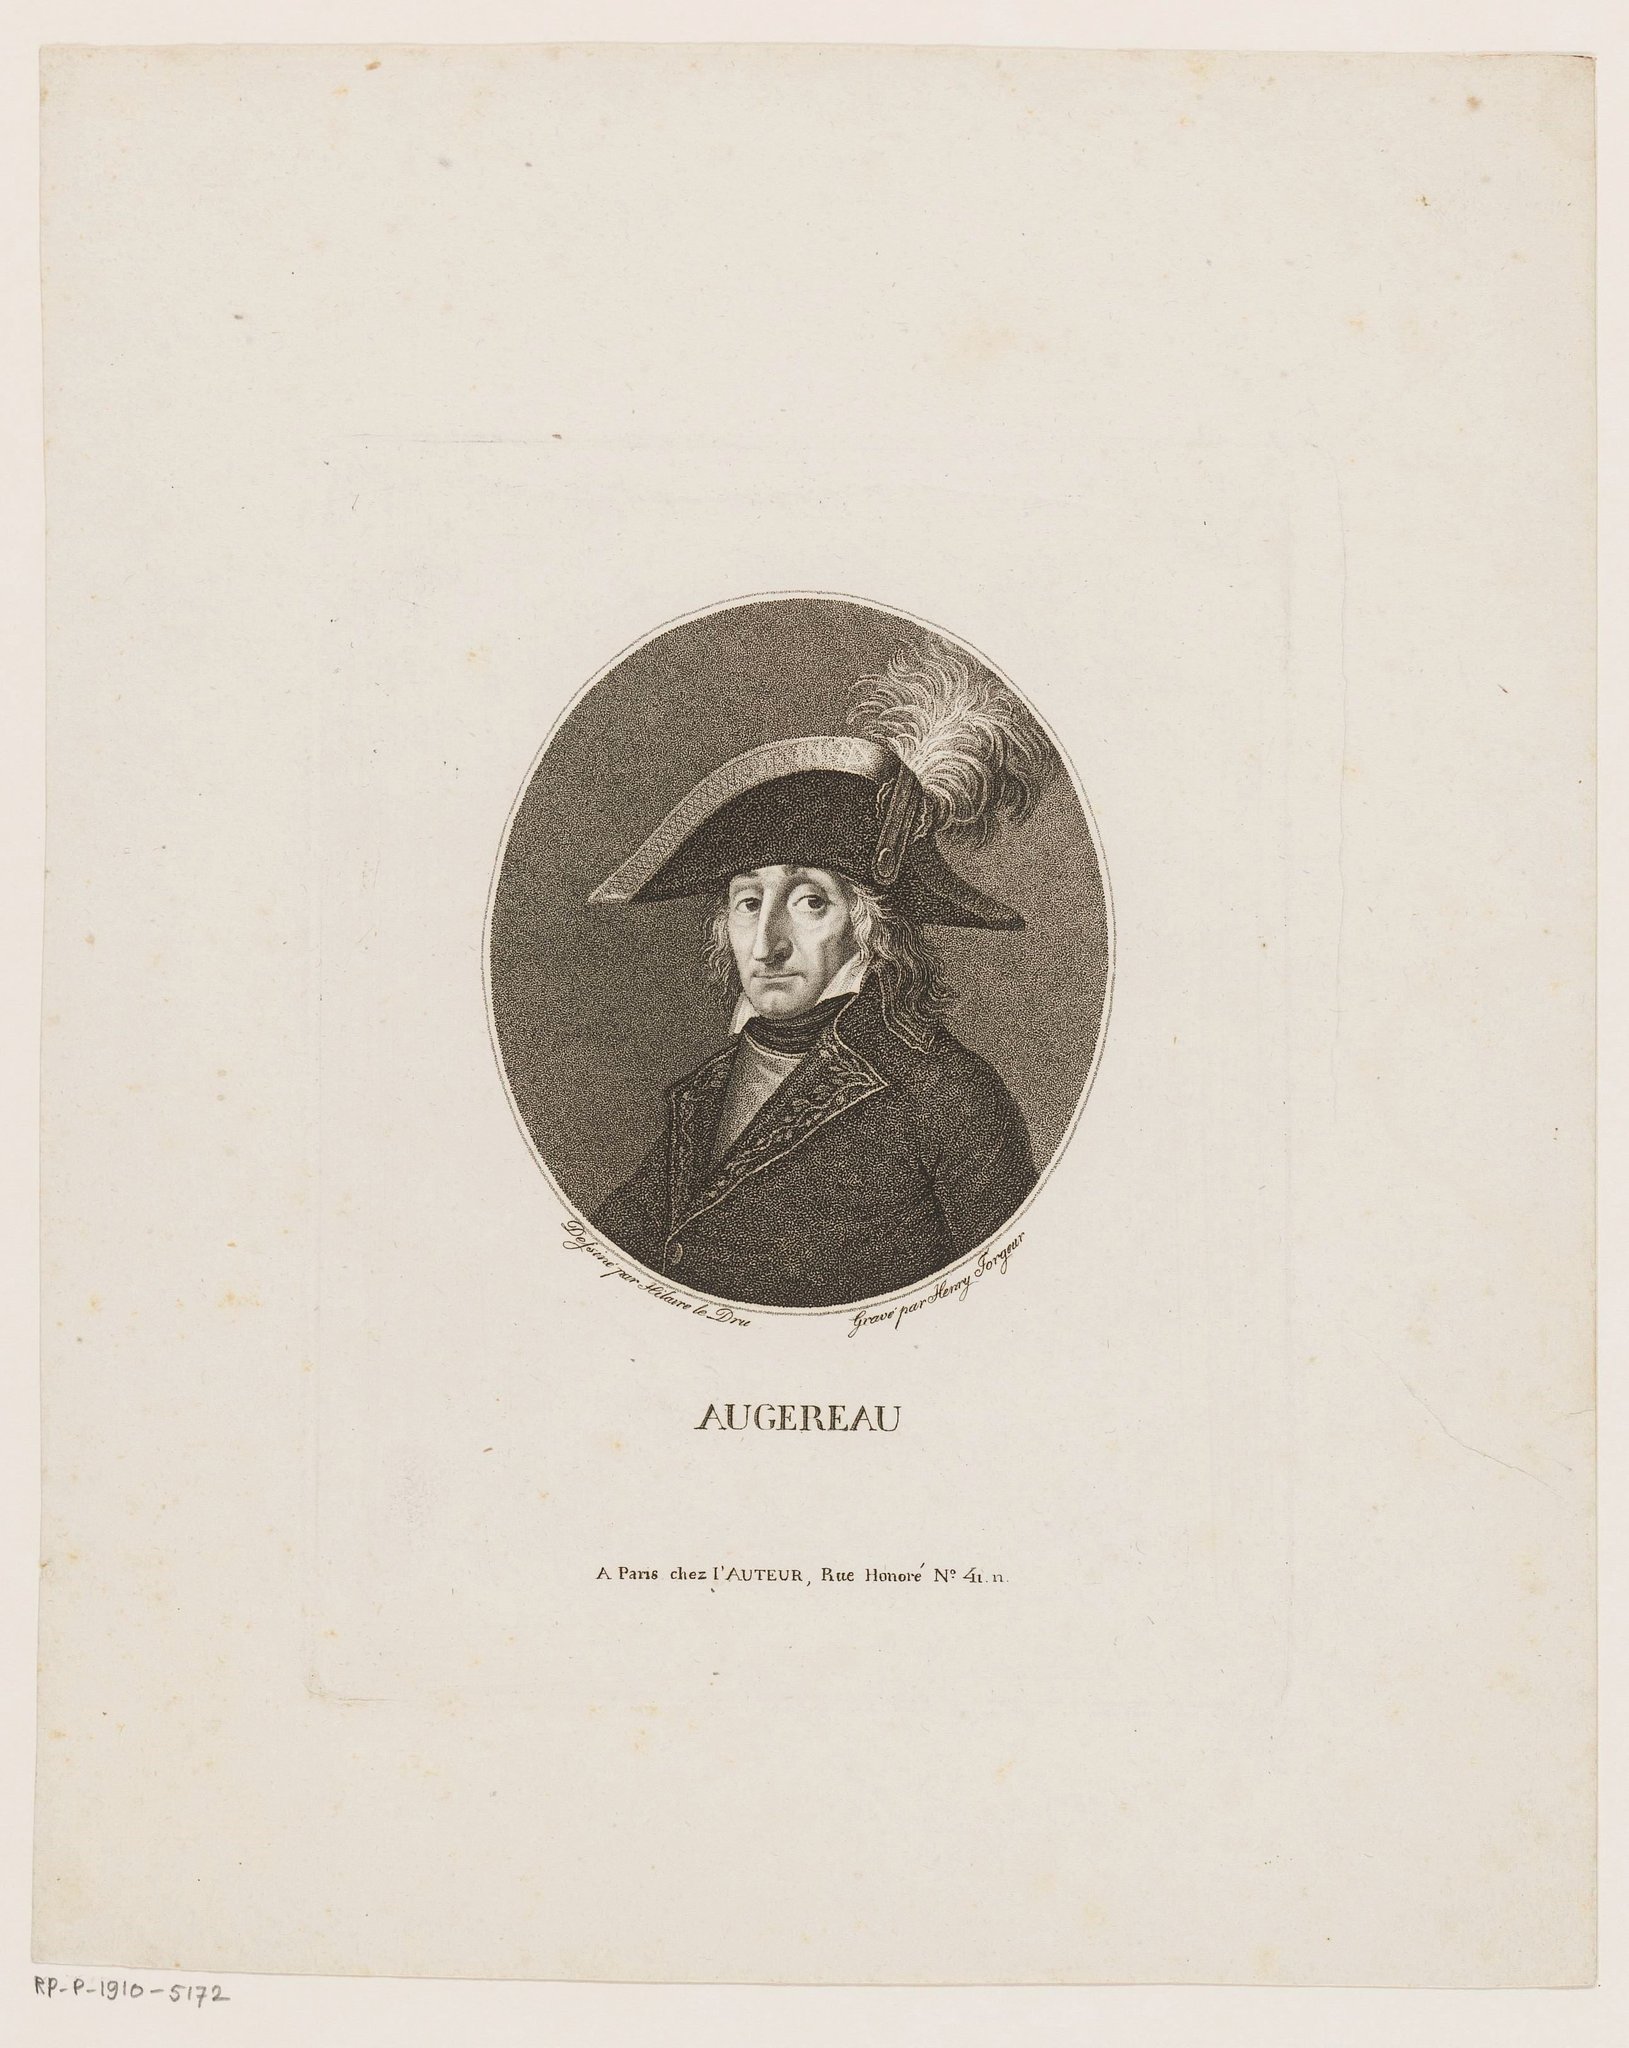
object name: print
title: Portret van Pierre François Charles Augereau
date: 1700-1799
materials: paper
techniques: engraving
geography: paris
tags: paris, politician, commander-in-chief, general, marshal, historical persons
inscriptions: collector's mark: Lugt 2228